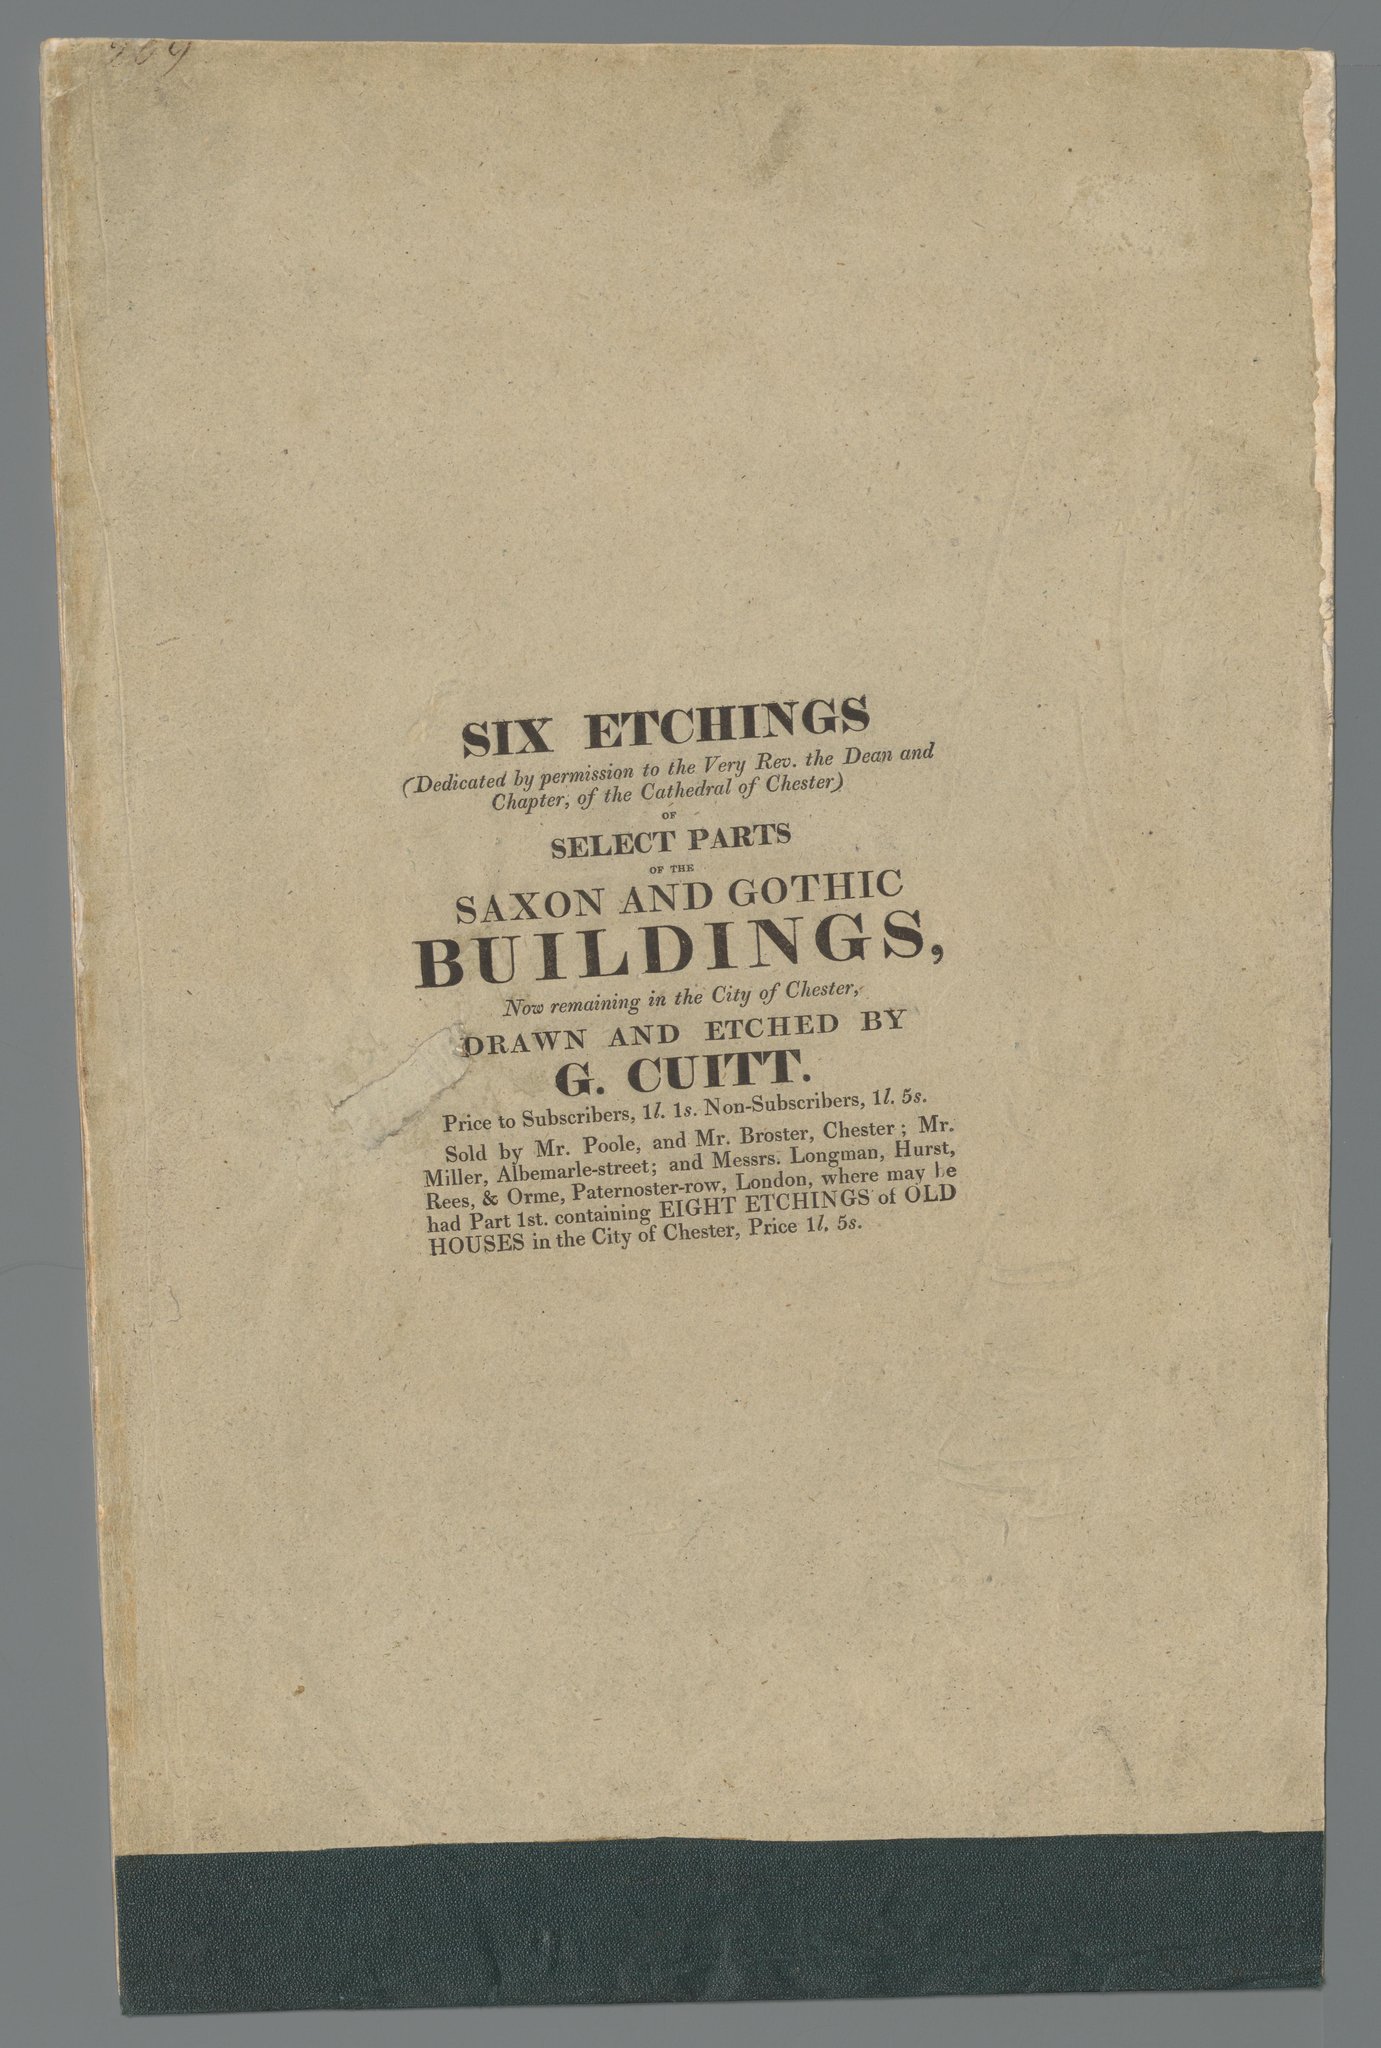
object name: prentrecueil, prentenalbum, prentalbum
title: Album met zes voorstellingen van gebouwen in Chester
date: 1811-1814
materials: linen, paper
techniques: bookbinding, etching, letterpress printing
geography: chester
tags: civic architecture; edifices; dwellings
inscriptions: collector's mark: Lugt 2760, collector's mark: Lugt 2228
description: Album met een serie getiteld 'Six Etchings of Select Parts of the Saxon and Gothic Buildings' met zes etsen op zes albumbladen.